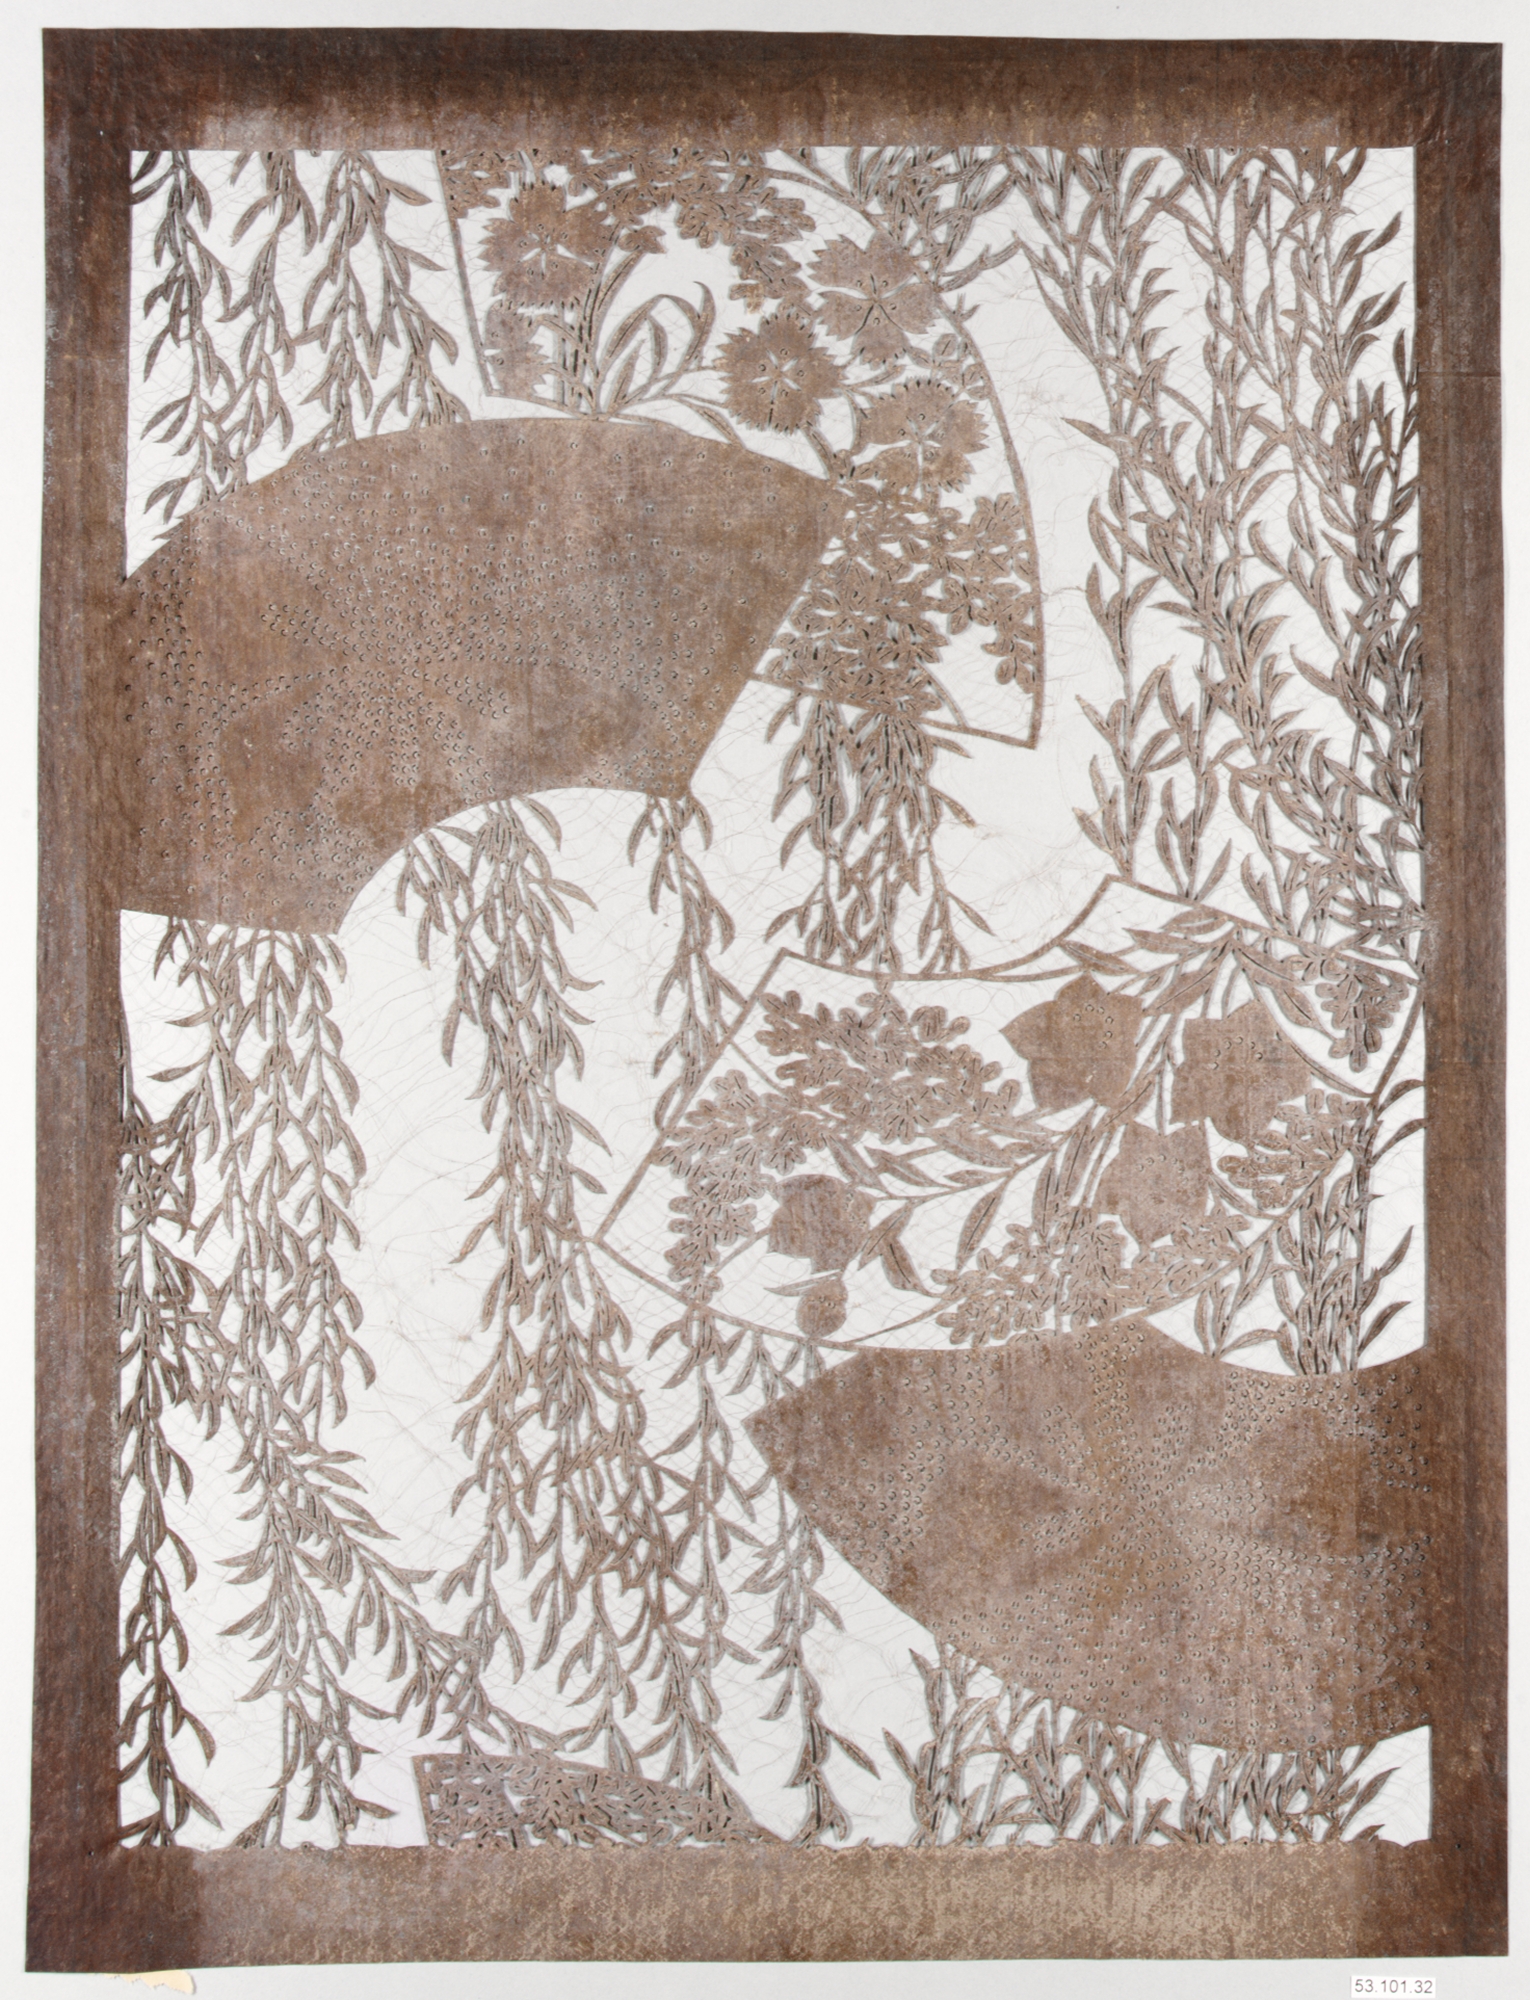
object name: stencil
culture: japanese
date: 1615-1868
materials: paper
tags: plants